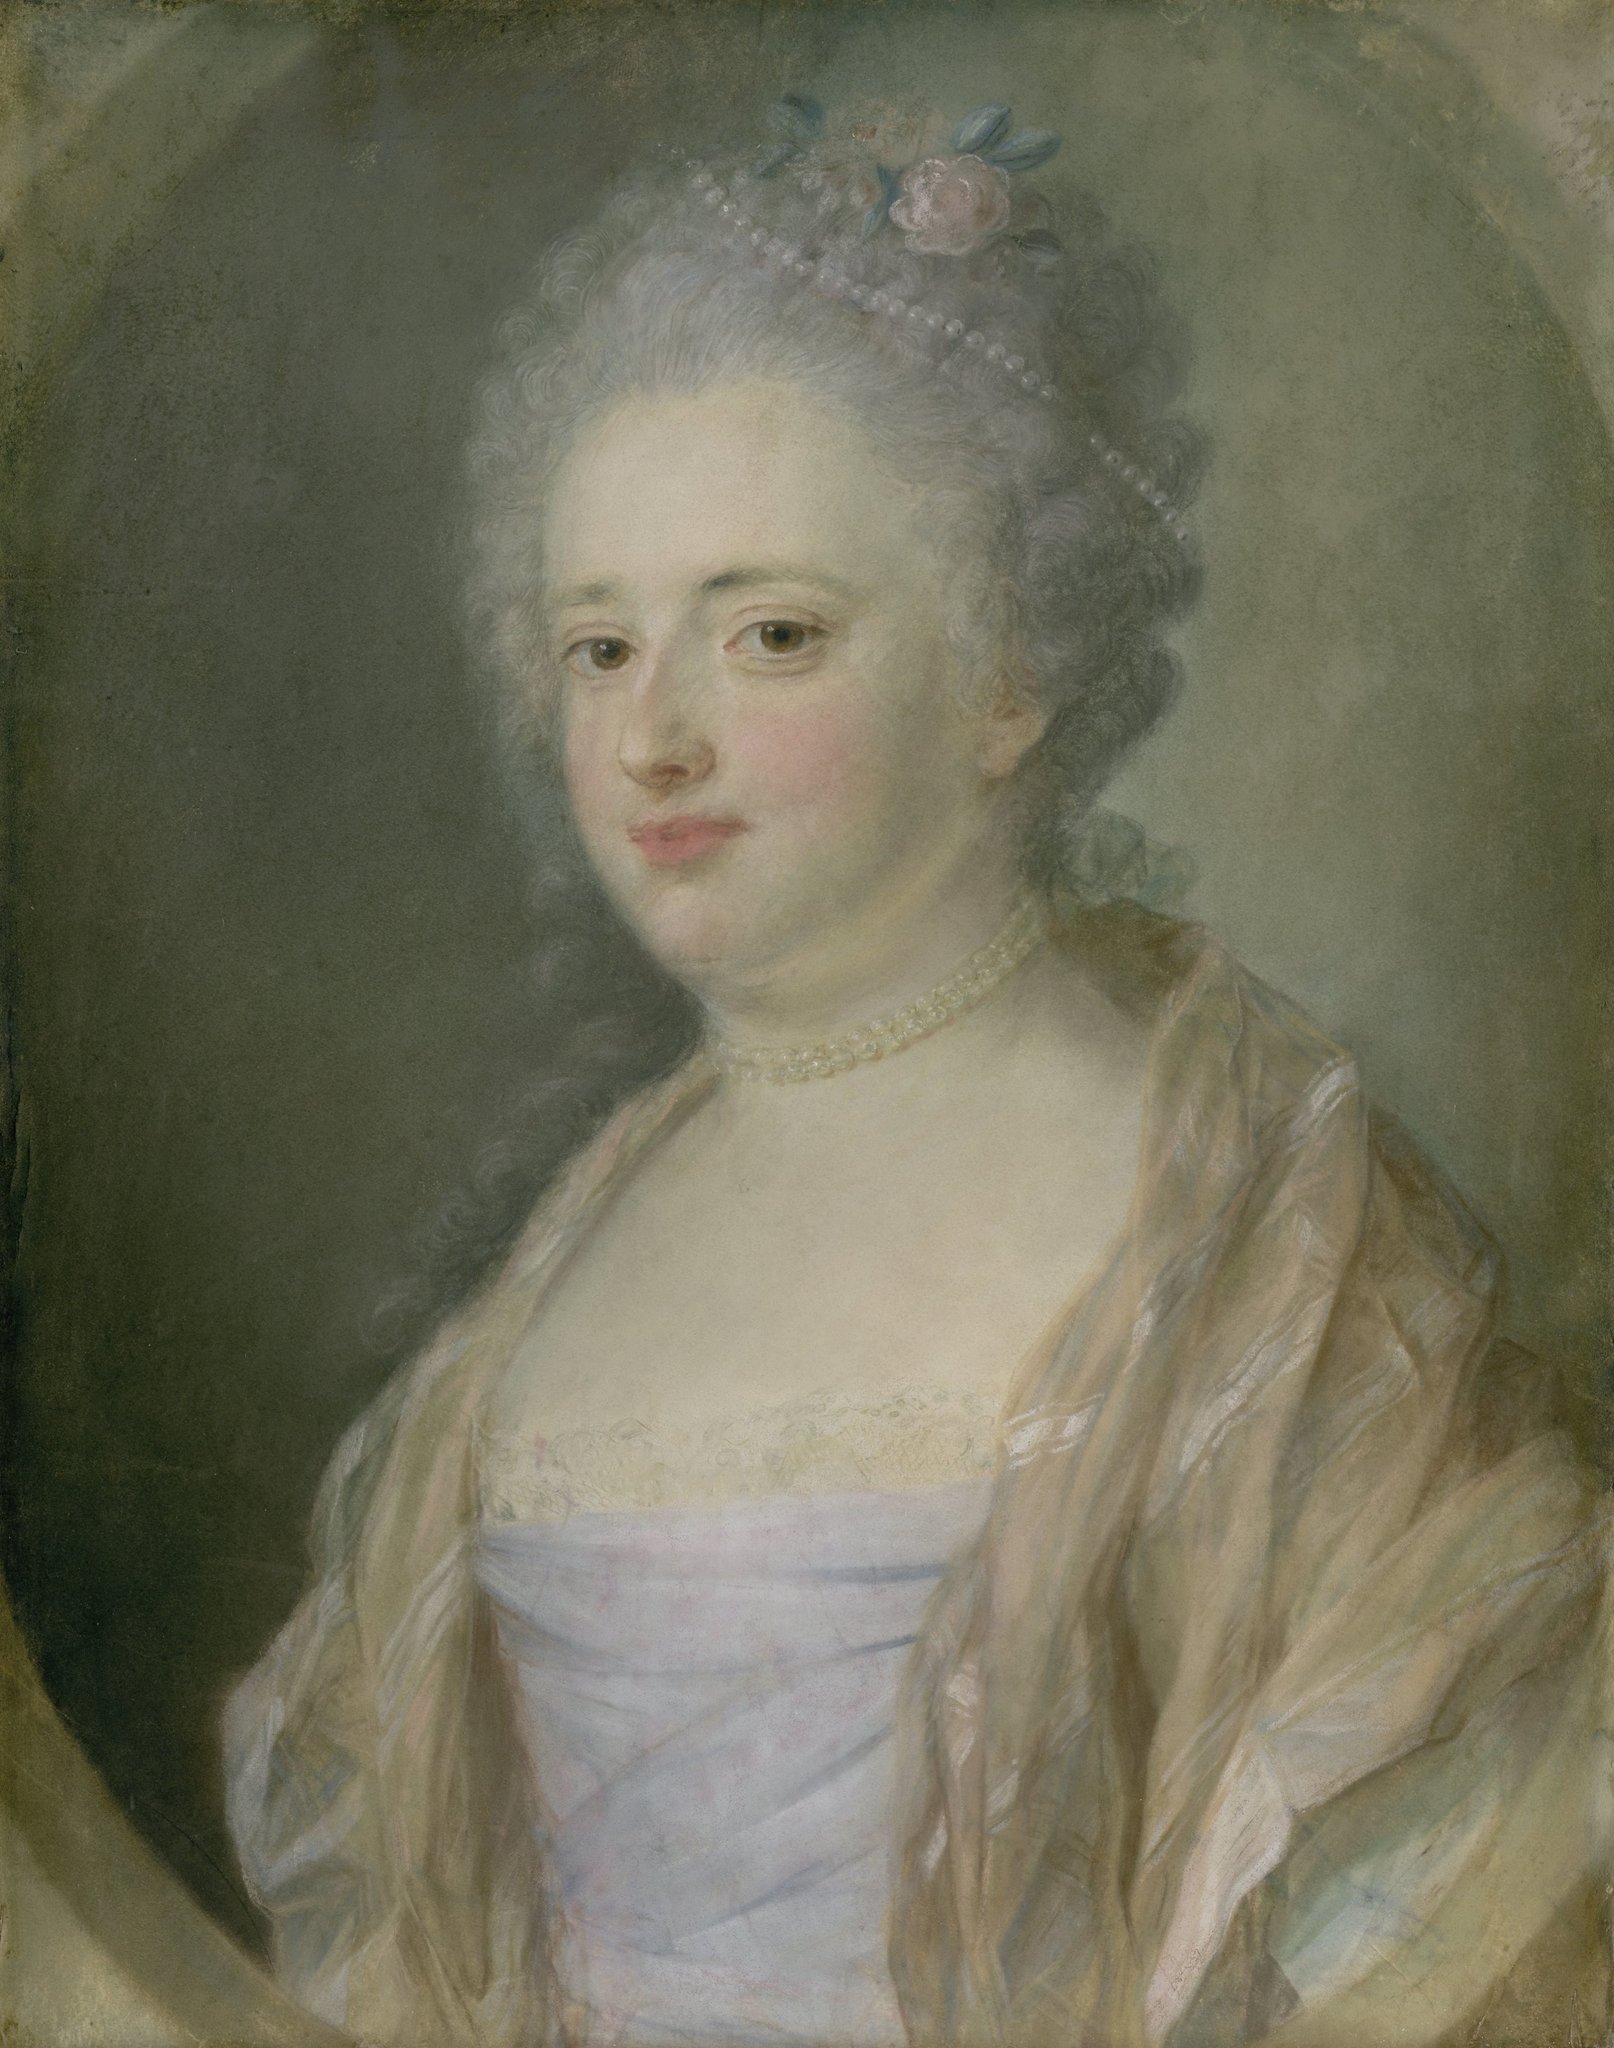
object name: drawing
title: Catharina Elisabeth Metayer (1744-1800)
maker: jean baptiste perroneau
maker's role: draughtsman, painter, print maker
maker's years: 1715-1783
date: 1765-1775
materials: parchment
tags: catharina elisabeth metayer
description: Jean-Baptiste Perronneau (1715 - 1783). Catharine Elisabeth Metayer (b 1744). J. Bernard van IJsseldijk bequest, Amsterdam, 1904.